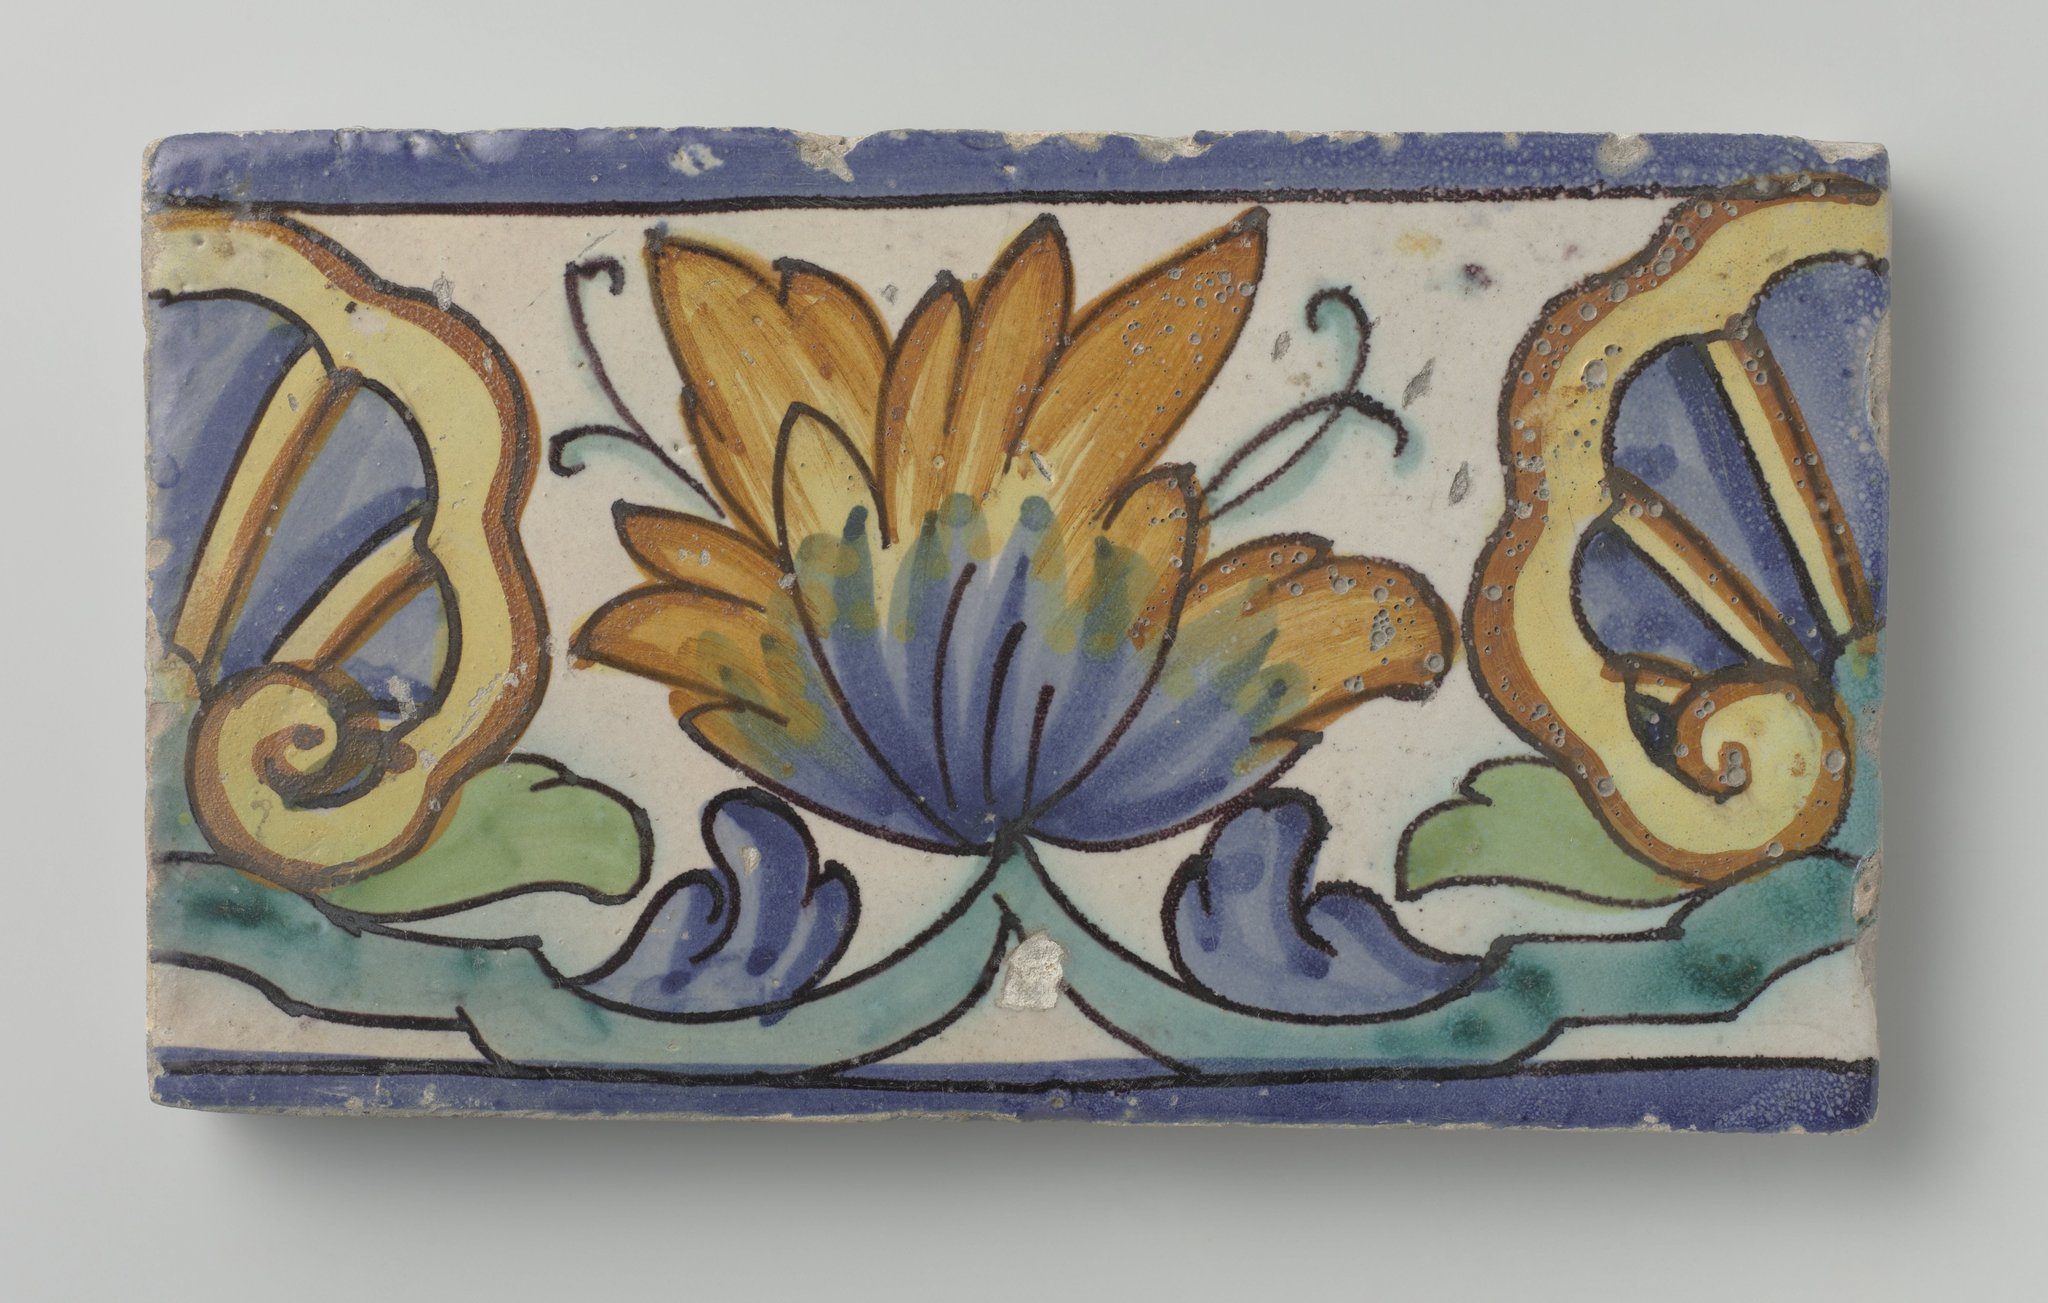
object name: randtegel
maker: Anonymous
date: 1650-1700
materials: earthenware, glaze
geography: spain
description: Randtegel, beschilderd in blauw, groen, geel, oranje, turkoois en mangaan. Bloem tussen gehalveerde schelpen. Aan boven- en onderzijde blauwe banden.